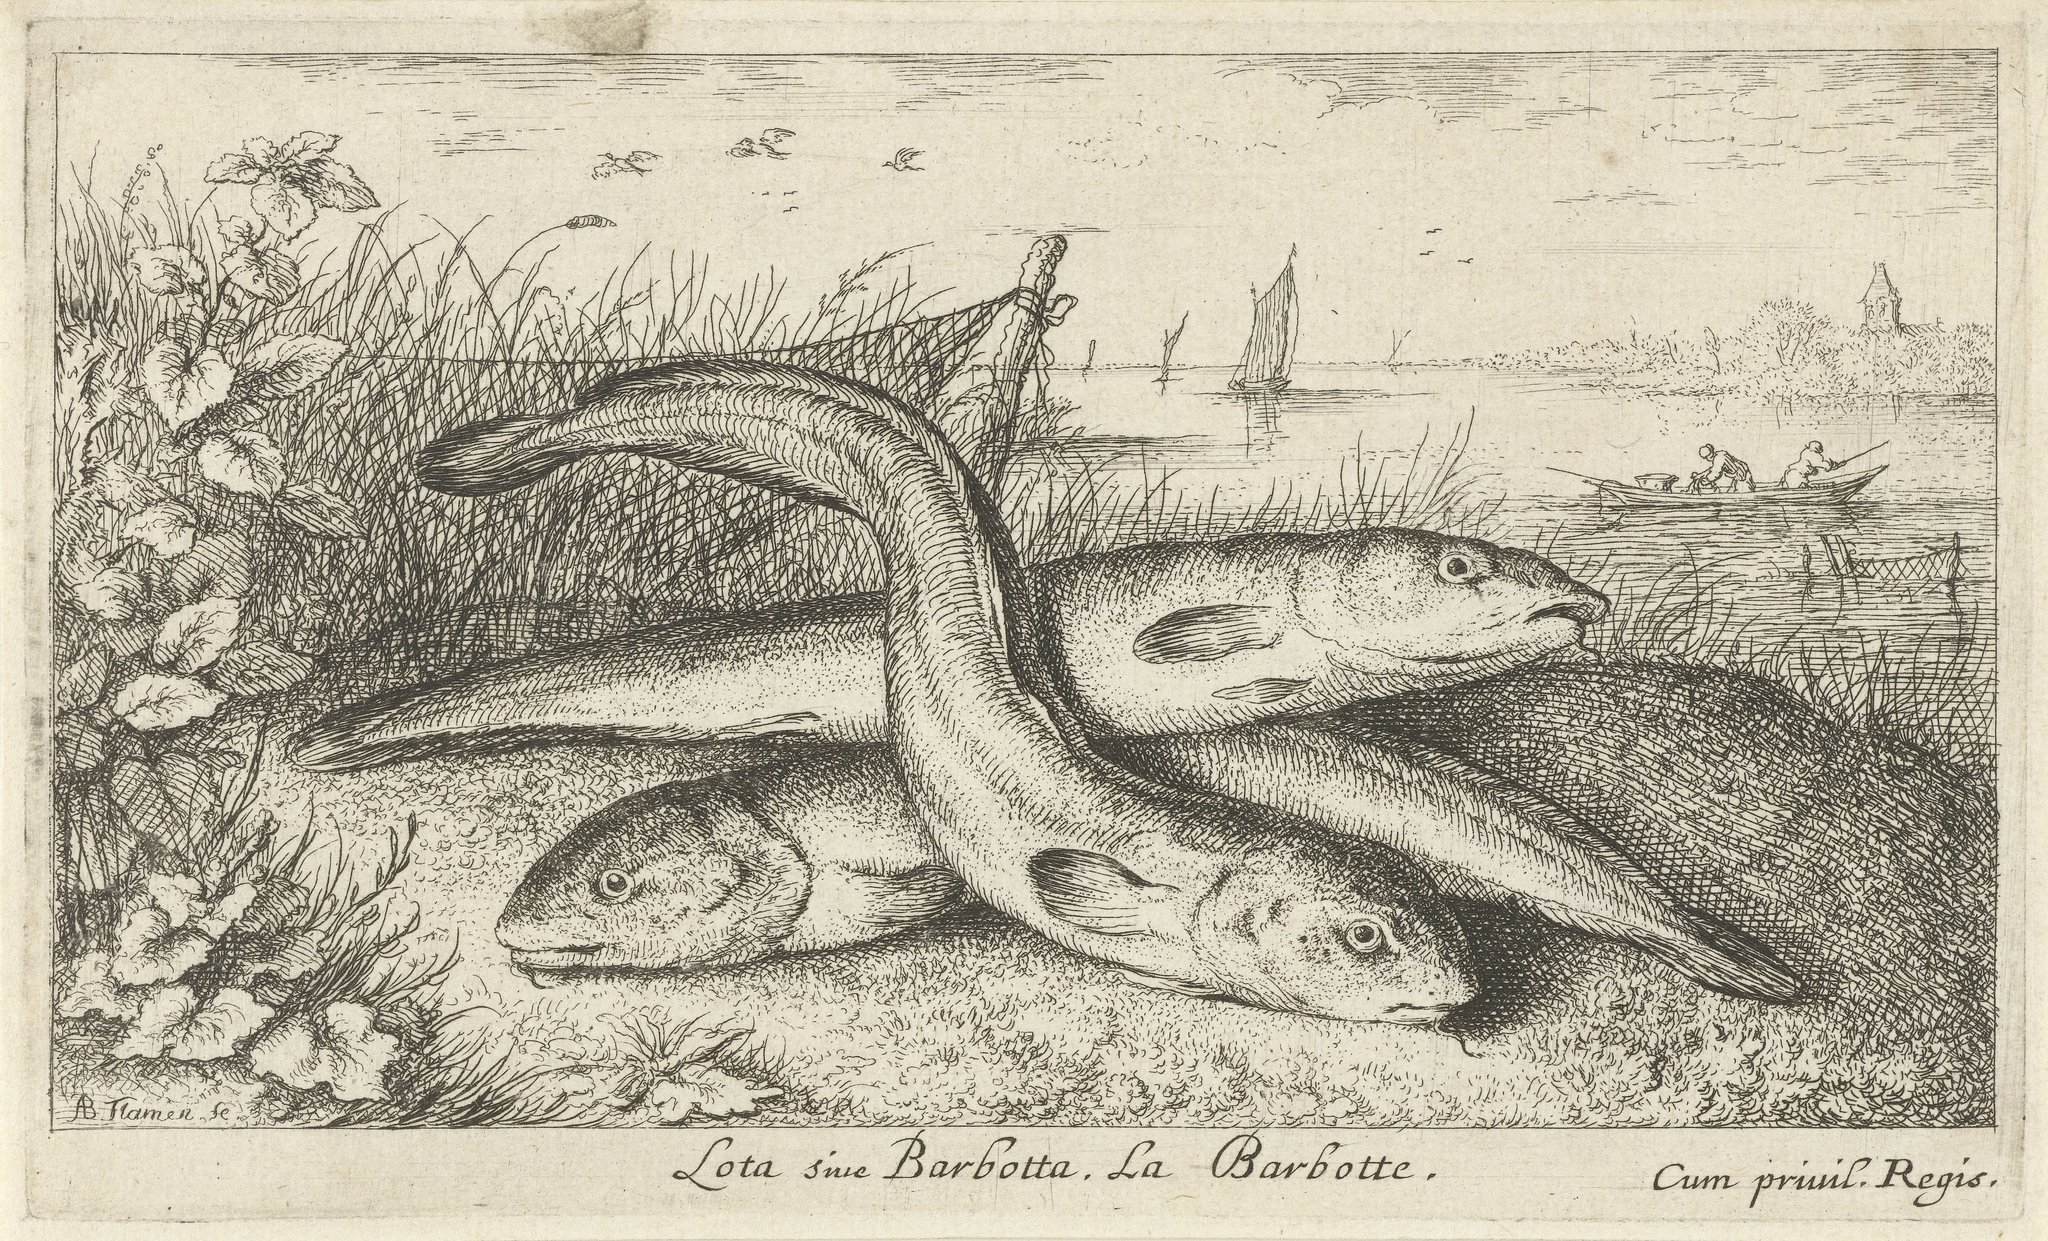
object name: print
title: Drie kwabalen op een rivier oever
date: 1664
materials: paper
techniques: etching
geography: paris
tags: eels: eel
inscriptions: collector's mark: Lugt 2228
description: Drie kwabalen liggen in het gras bij een visnet. Op de achtergrond twee personen in een vissersboot op de rivier.